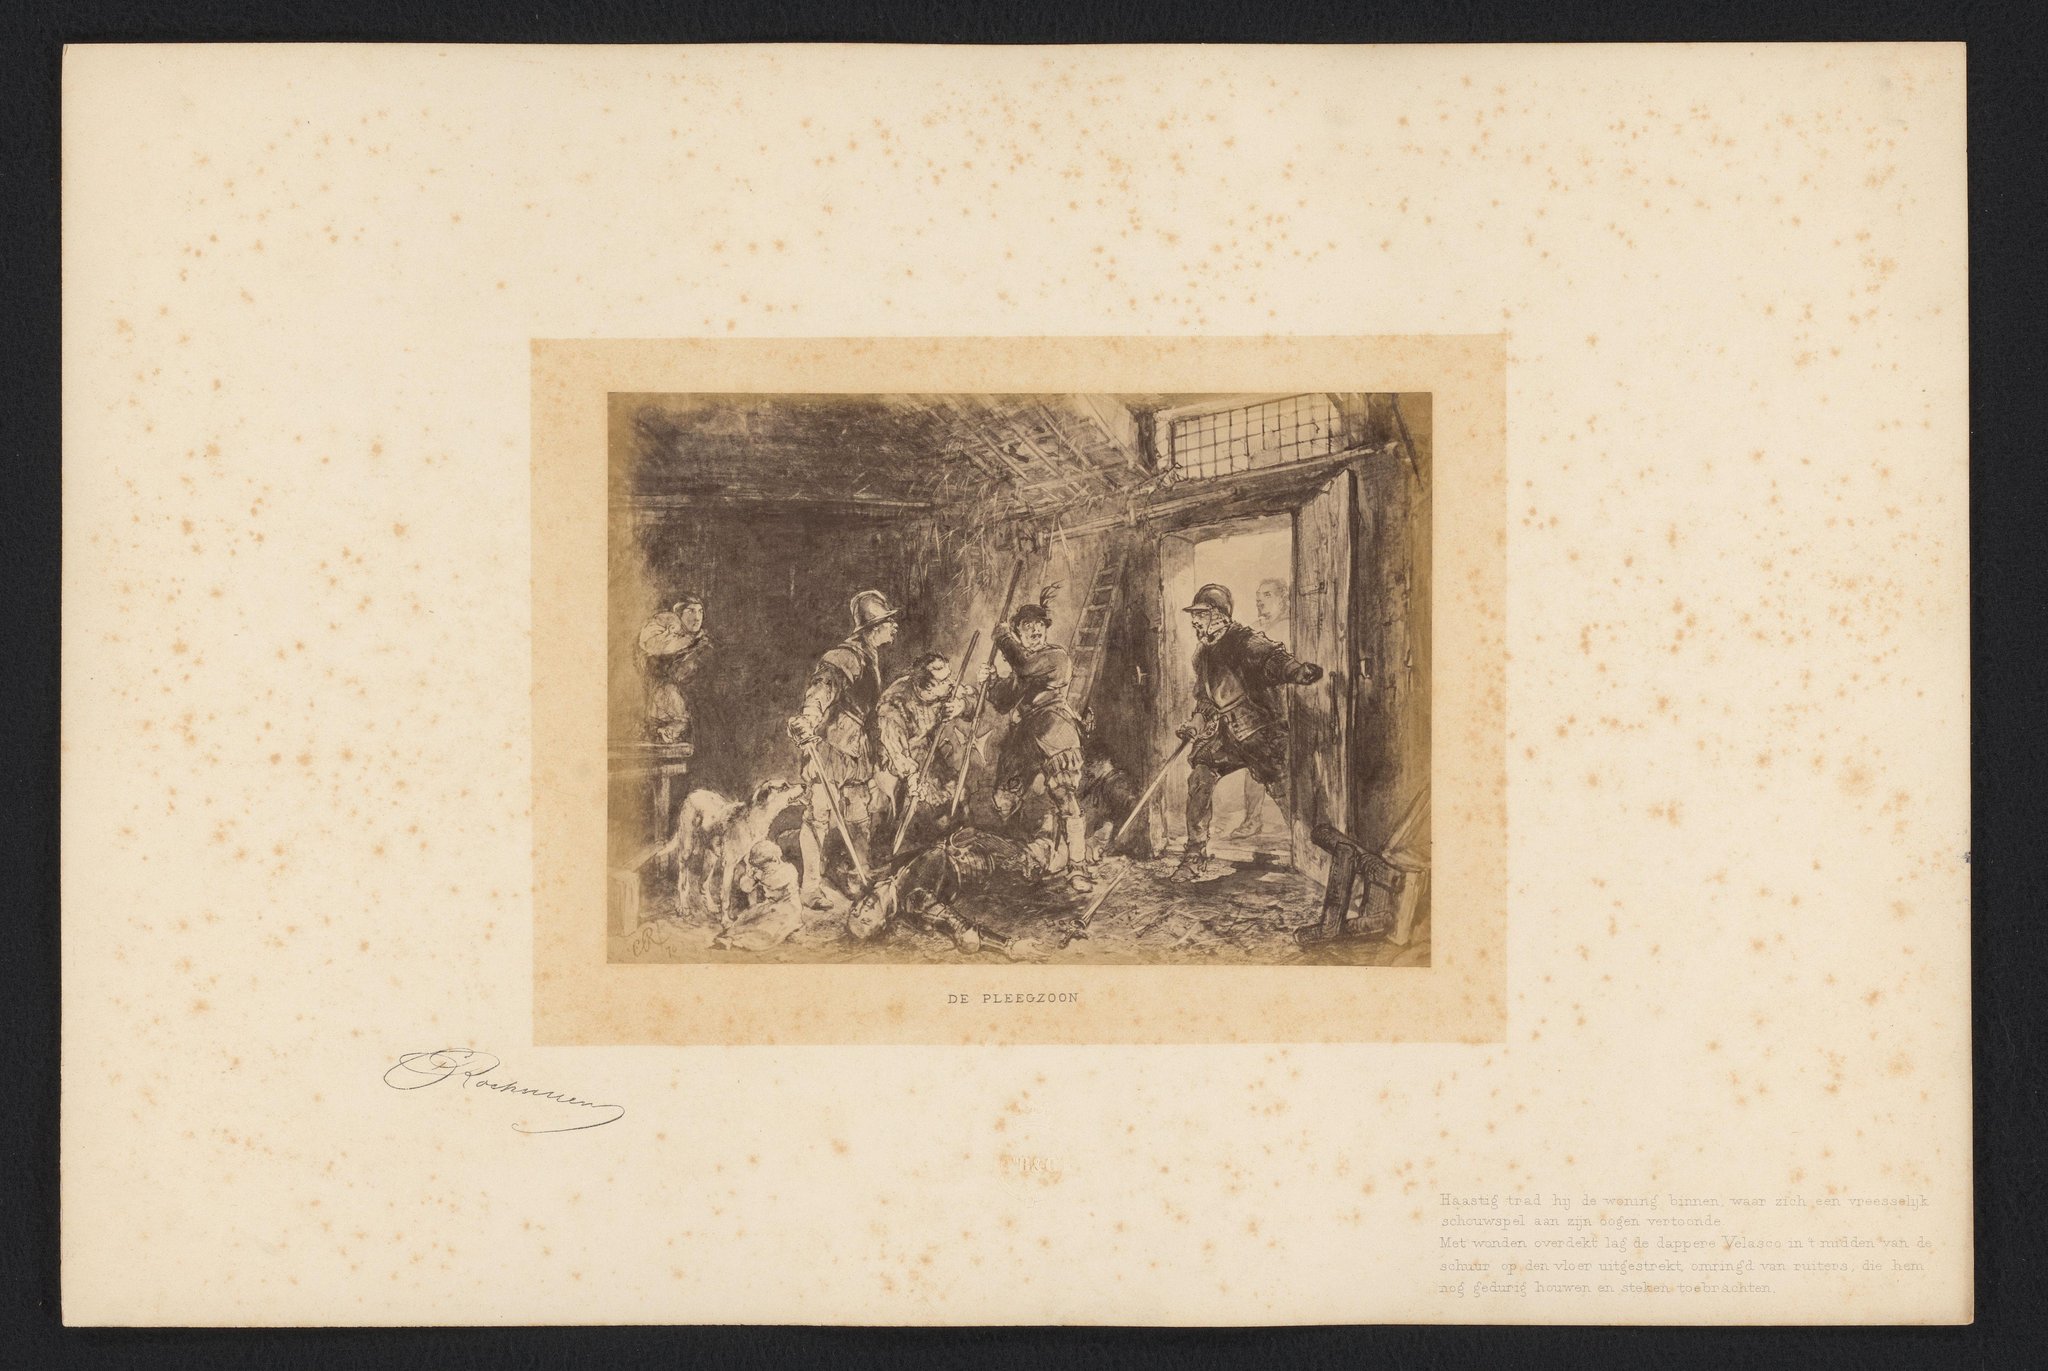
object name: reproduction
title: Fotoreproductie van een tekening van een scène uit het verhaal De Pleegzoon door Charles Rochussen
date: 1870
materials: cardboard, paper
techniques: albumen print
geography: haarlem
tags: murder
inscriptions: inscription: ‘Haastig trad hij (...) en steken toebrachten.’, signature: ‘C Rochussen’